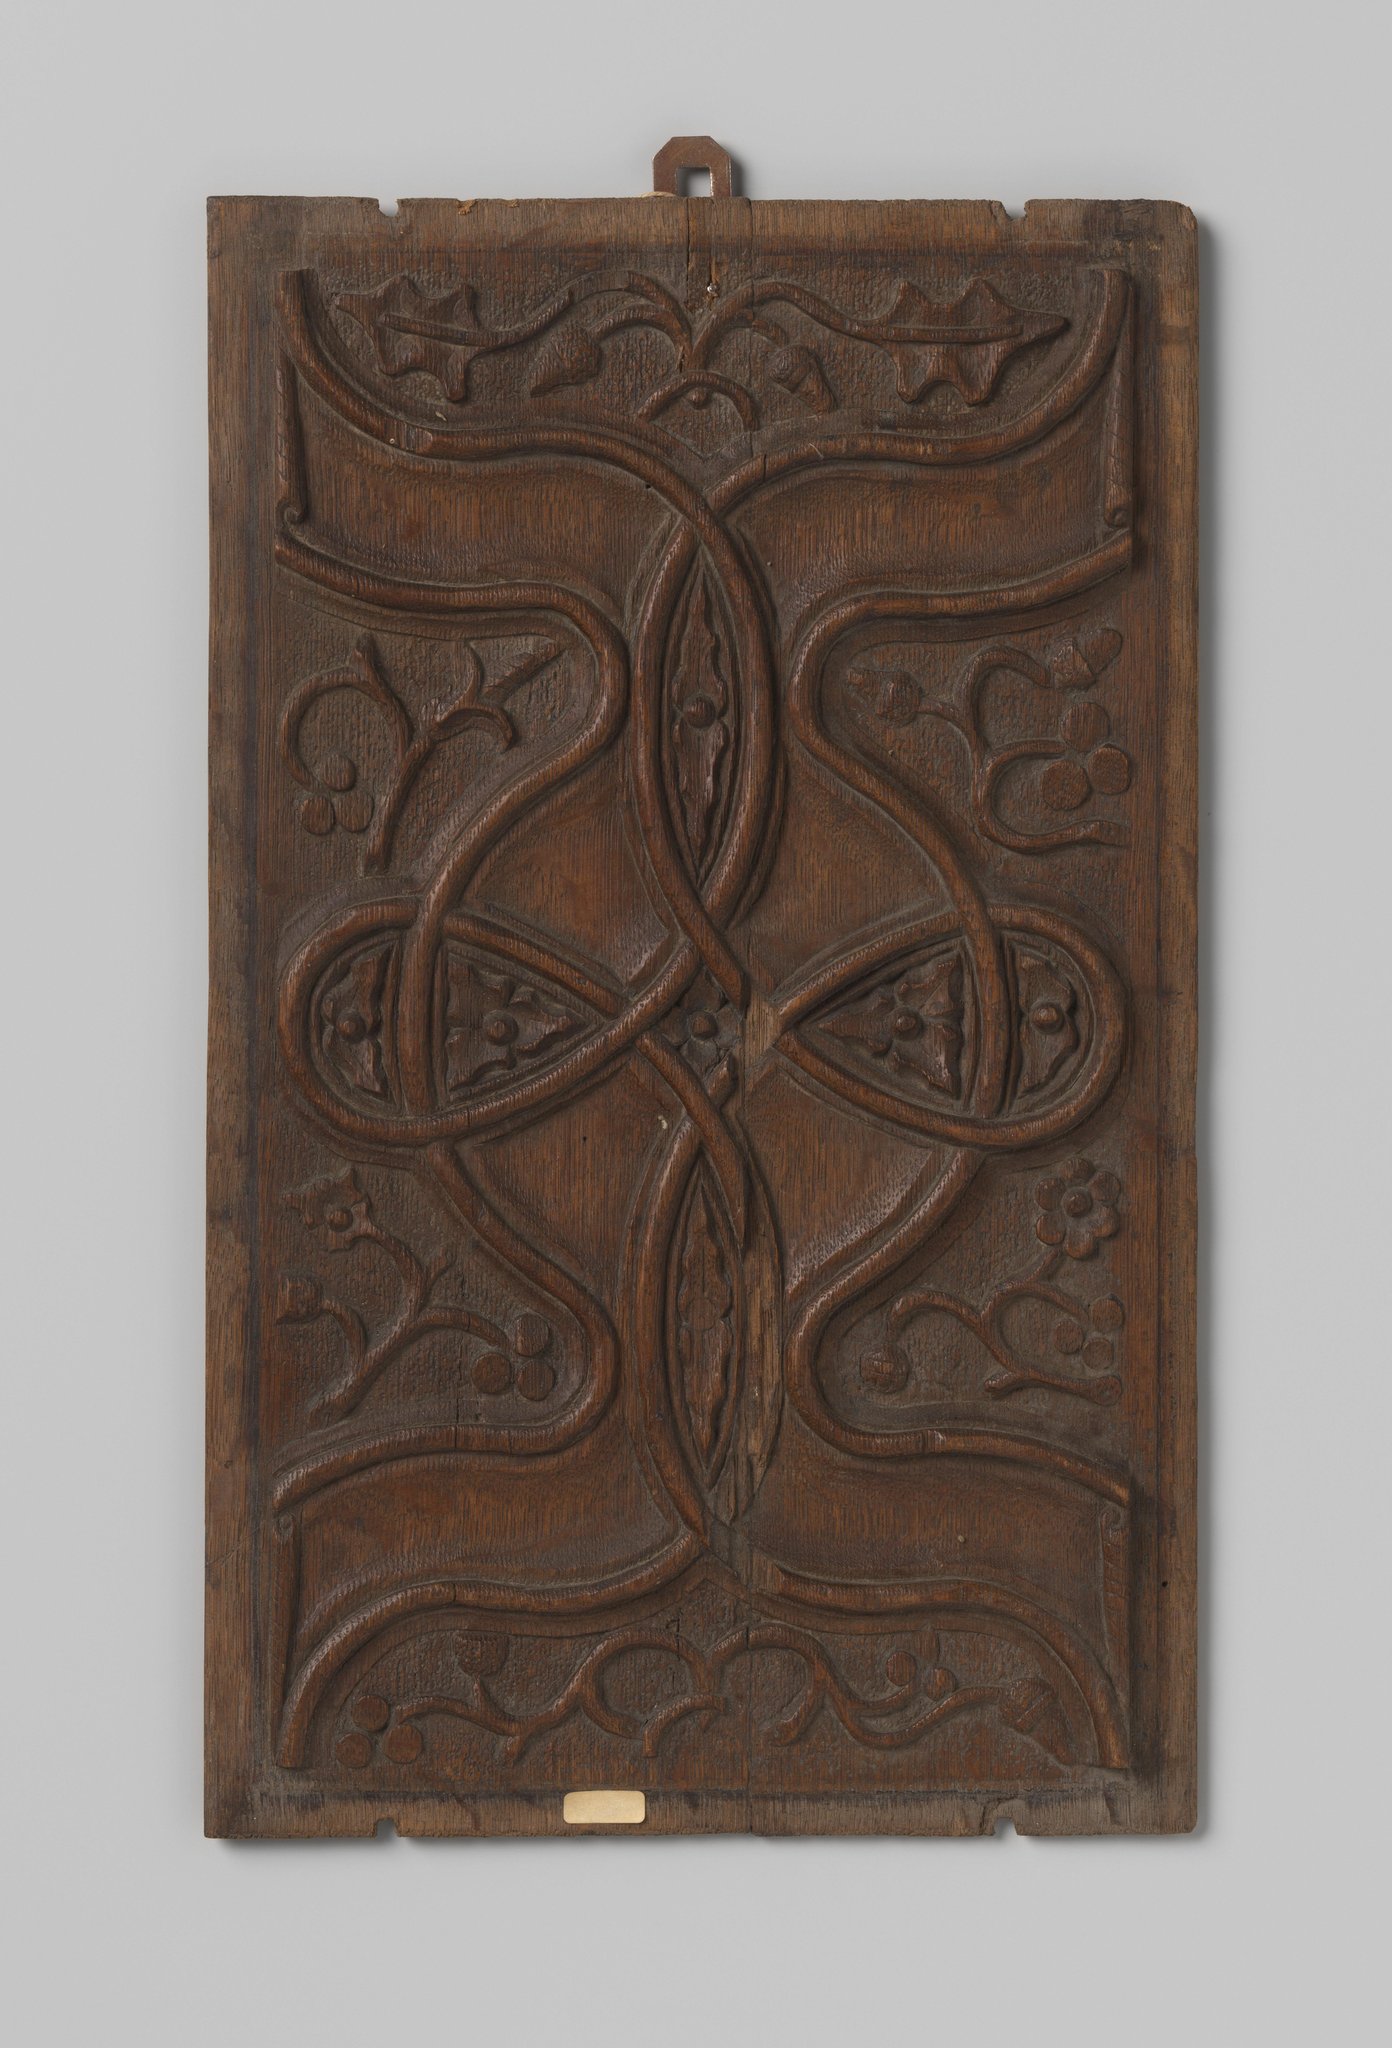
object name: architectural element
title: Interieuronderdeel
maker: Anonymous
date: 1500-1550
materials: wood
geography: netherlands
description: Paneel, versierd met de uit de "brief" ontwikkelde bladslingers, die een kabeling in het midden vertonen en wingerdtakjes met druiventrossen in de uitgrondingen hebben.